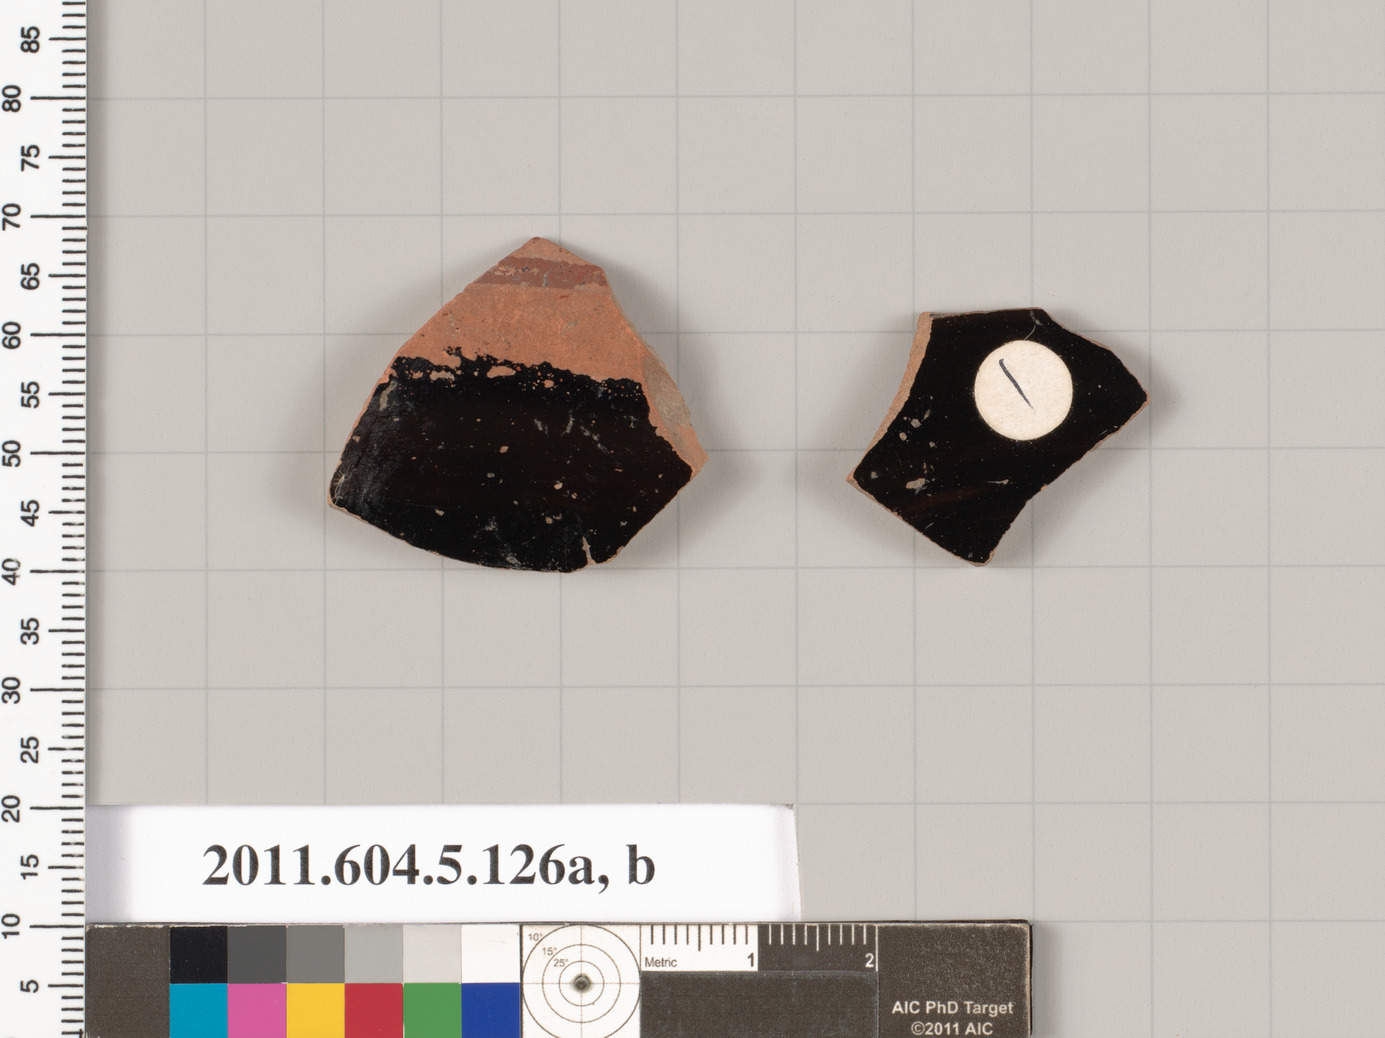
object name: kylix fragment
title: Terracotta fragments of stemless kylikes (drinking cups)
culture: greek, attic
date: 470-450 BCE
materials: terracotta